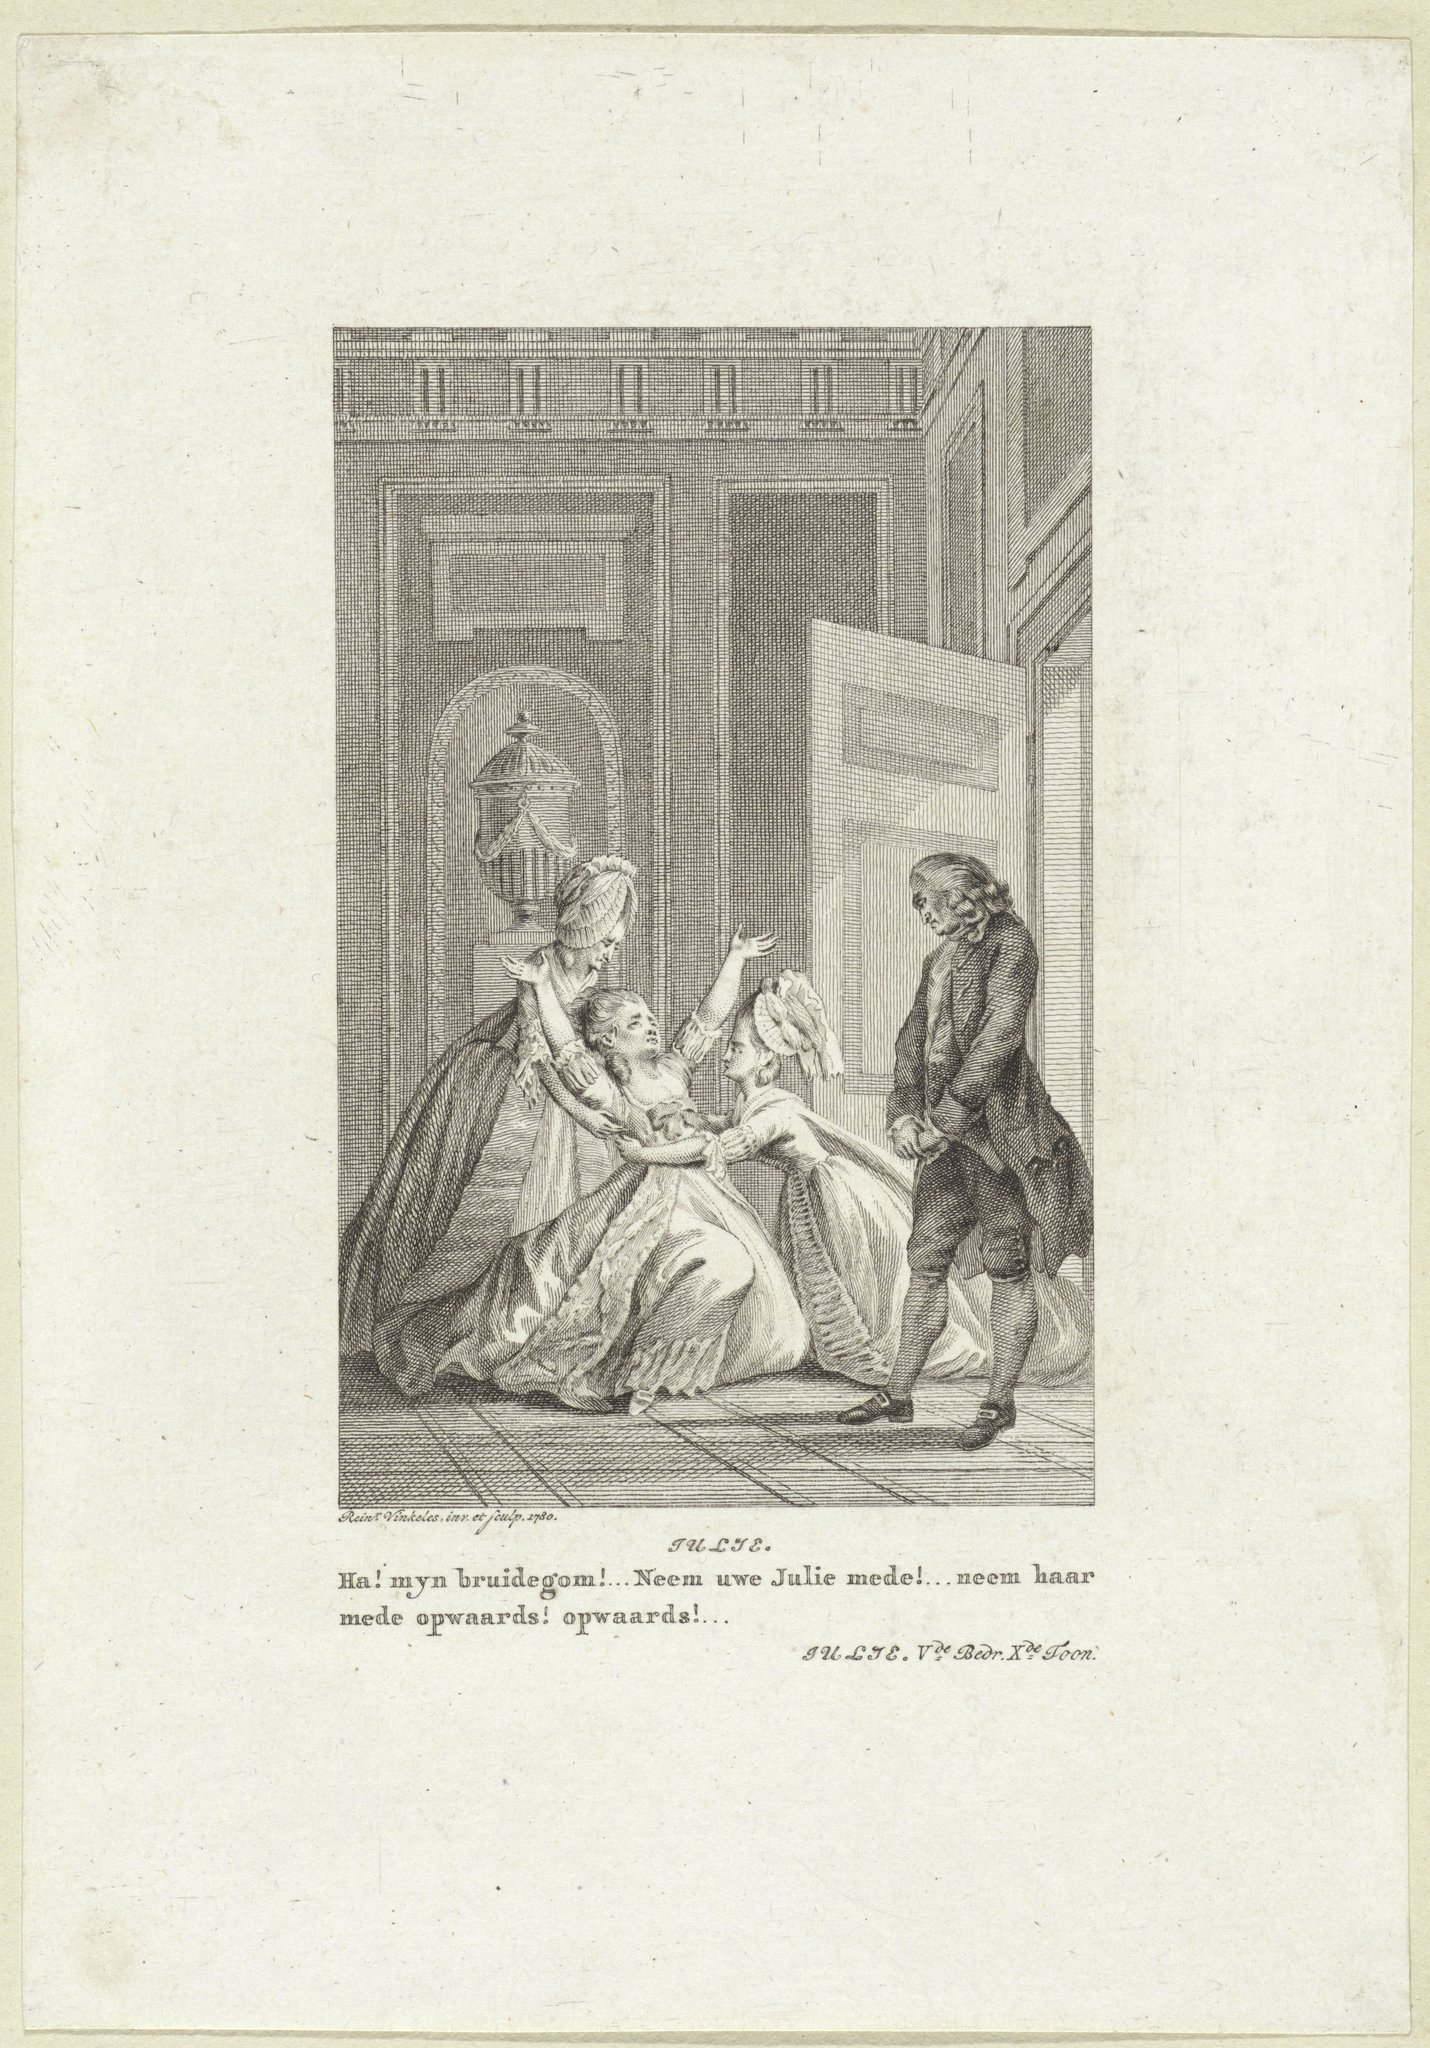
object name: print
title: Julie vraagt haar man wanhopig om haar mee te nemen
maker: reinier vinkeles (i)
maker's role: draughtsman, print maker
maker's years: 1741-1816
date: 1780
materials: paper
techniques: engraving, etching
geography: amsterdam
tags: kneeling figure, man and wife quarrelling, 'marriage à la mode'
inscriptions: collector's mark: Lugt 240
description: Deze prent is mogelijk gebruikt als illustratie voor: Stortz, Helfrich Peter. Julie: burgerlyk treurspel. Amsterdam: Pieter Meĳer, 1780.